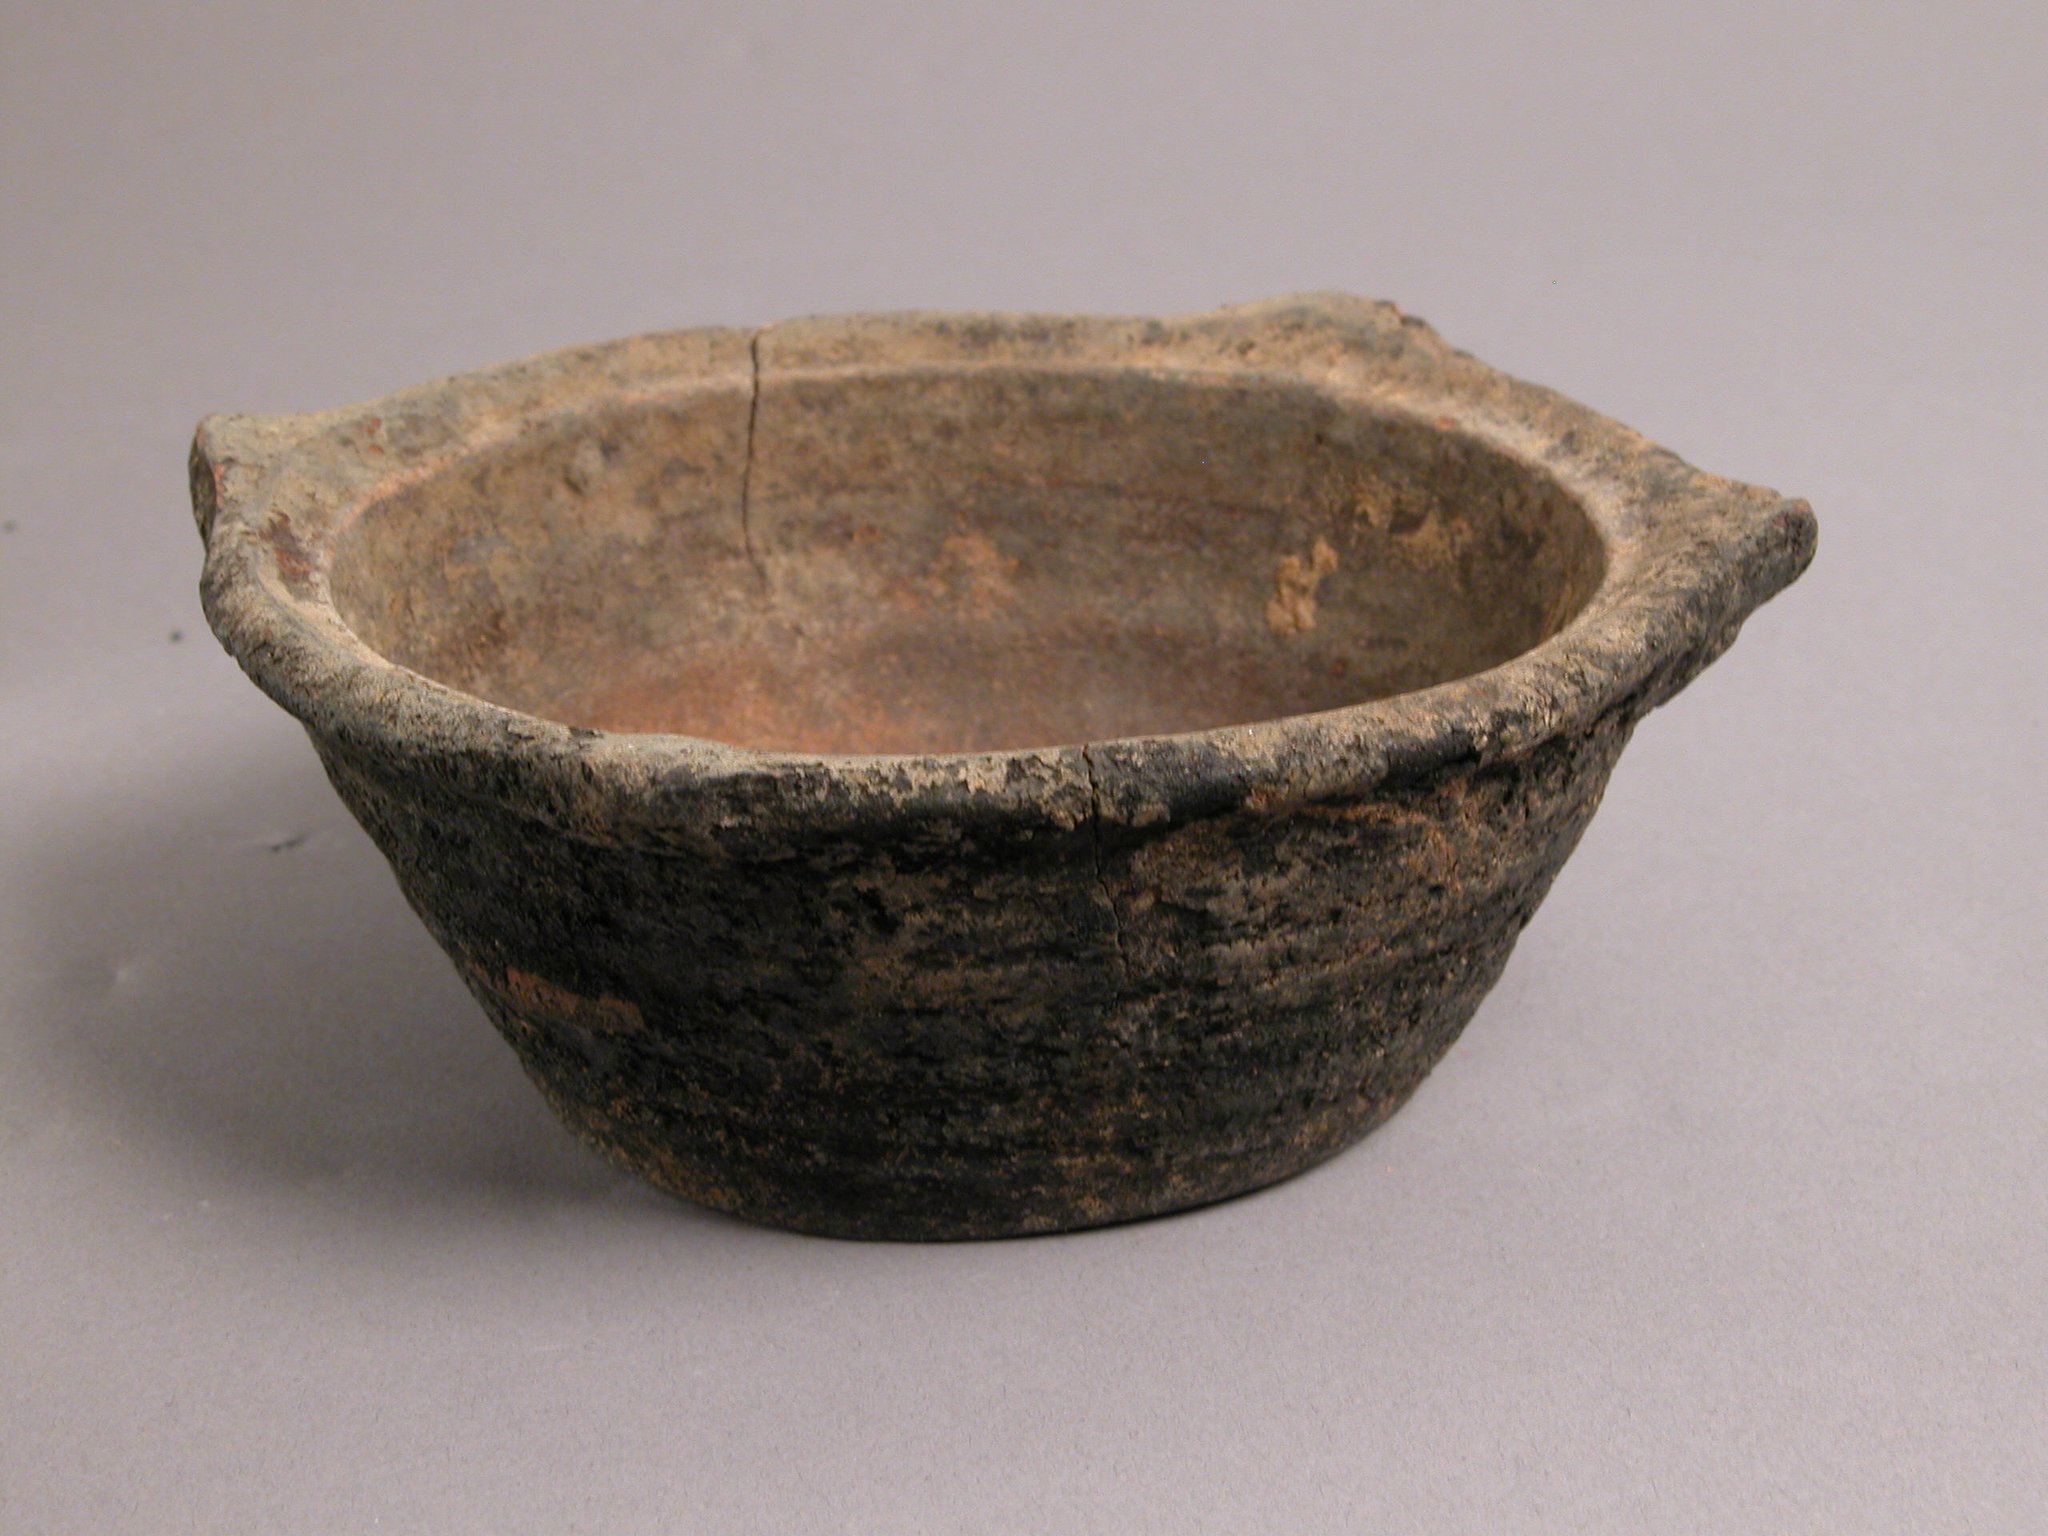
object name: bowl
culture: coptic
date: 301-700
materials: earthenware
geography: egypt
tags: bowls